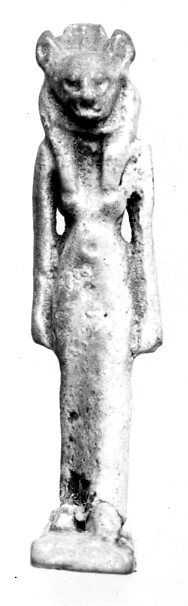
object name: amulet, sakhmet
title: Sakhmet Amulet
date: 664-630 BCE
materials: faience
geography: egypt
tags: sekhmet